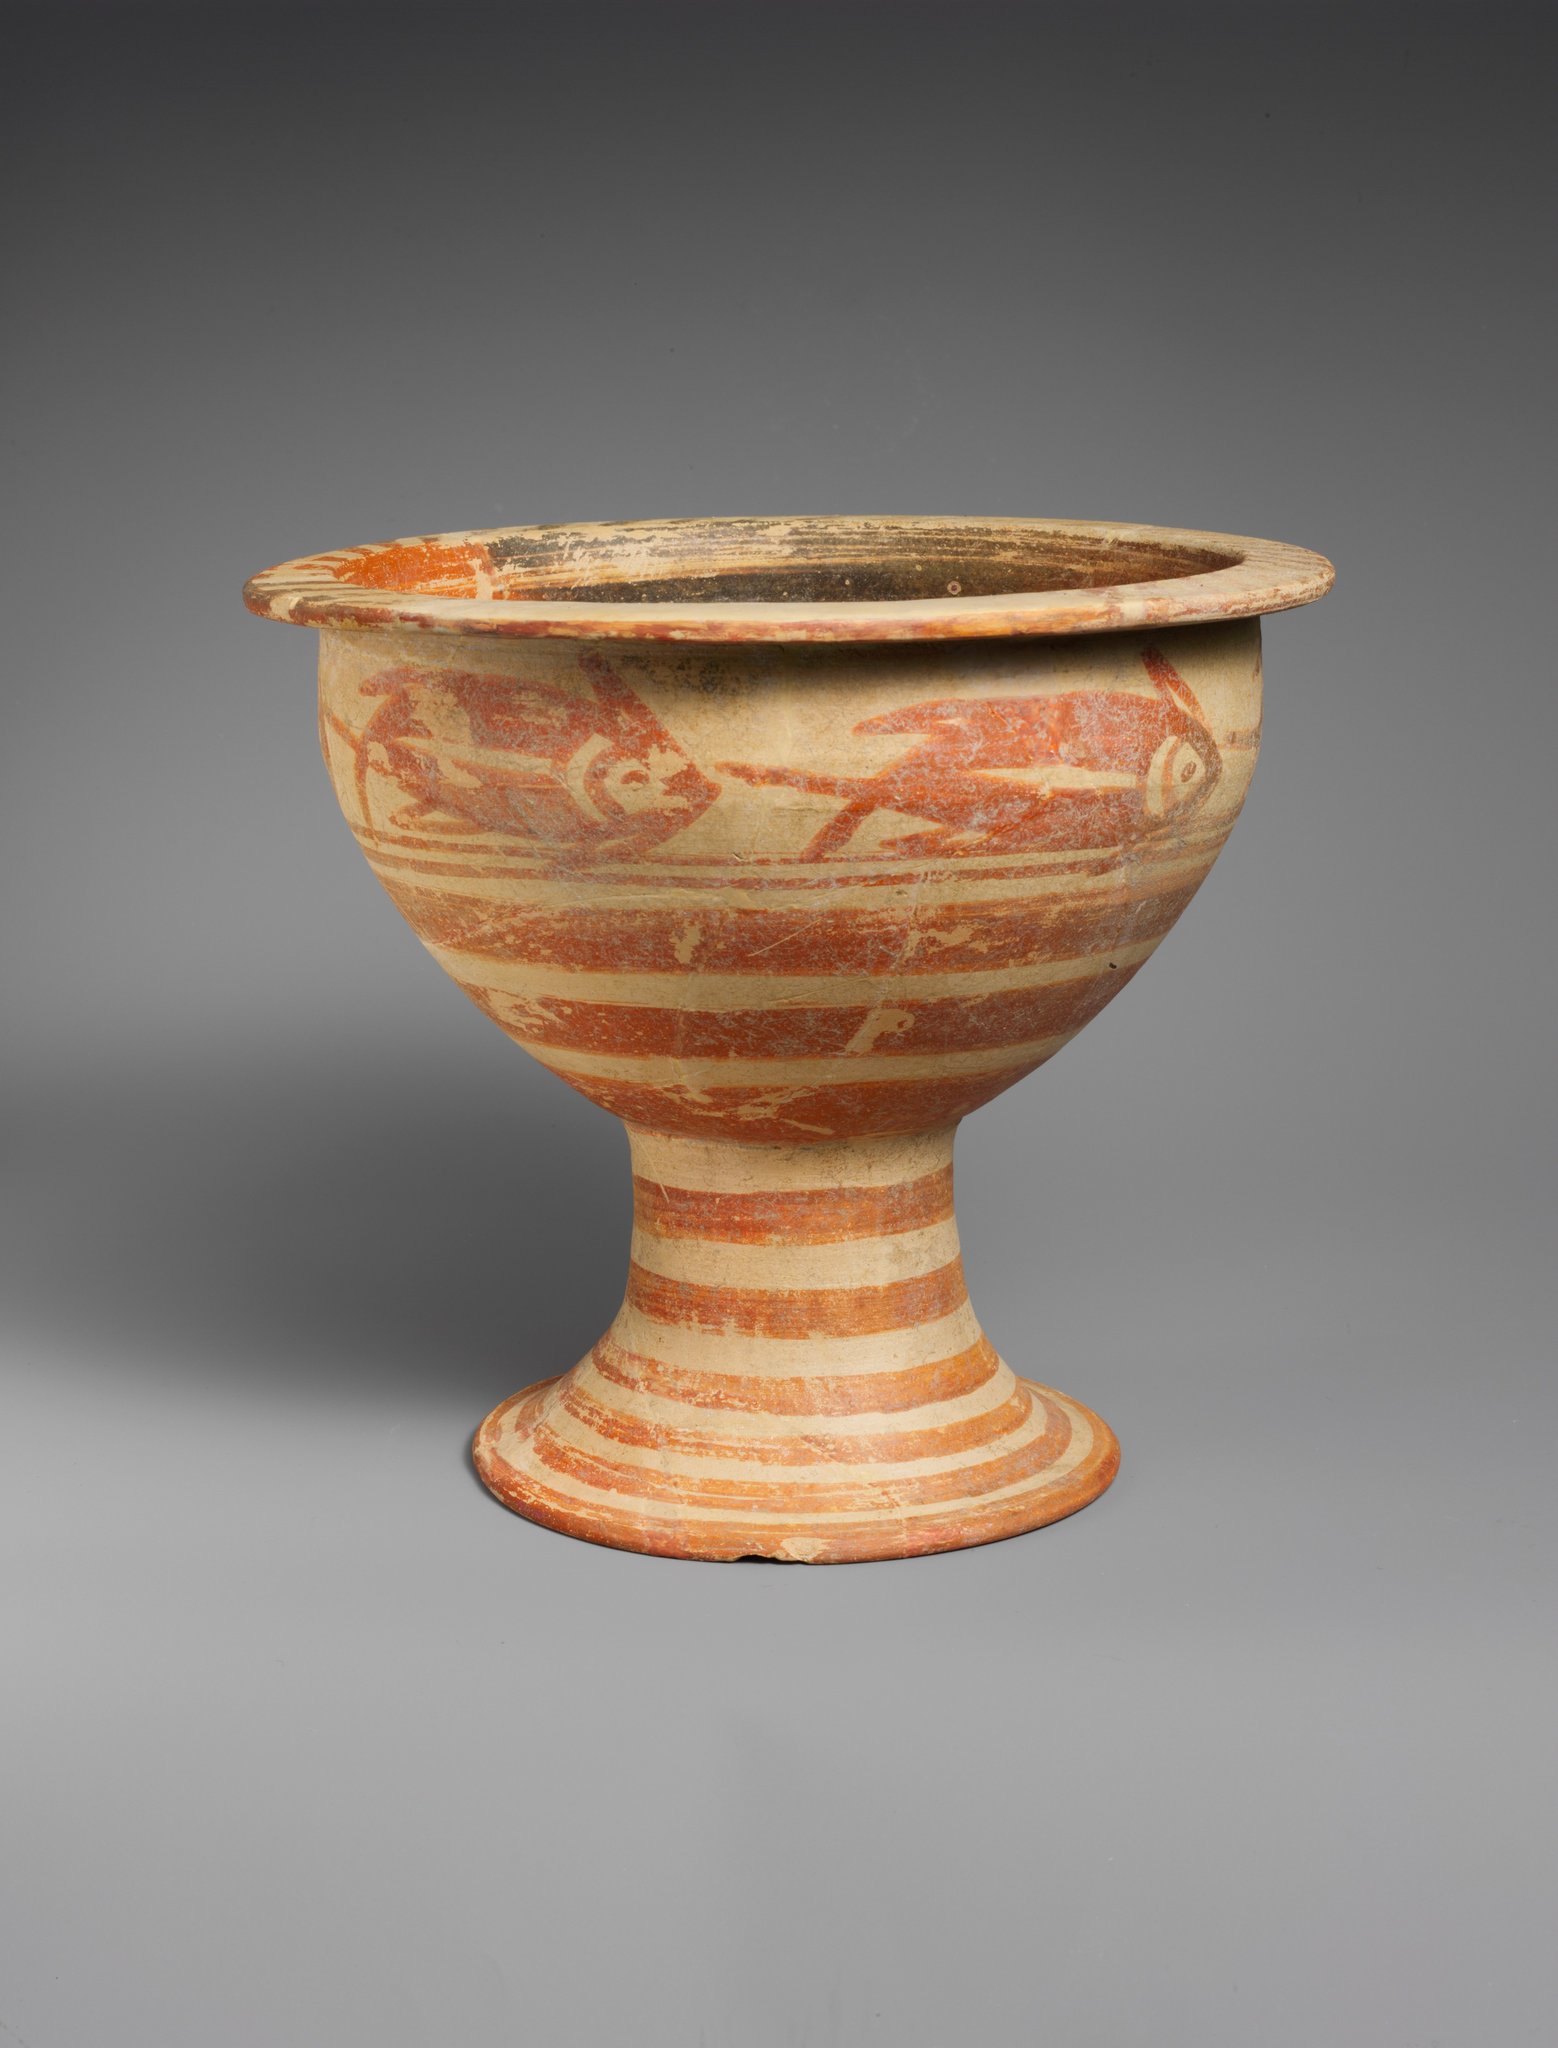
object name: bowl, stemmed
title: Terracotta footed bowl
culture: etruscan, italo-geometric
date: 625-600 BCE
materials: terracotta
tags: fish